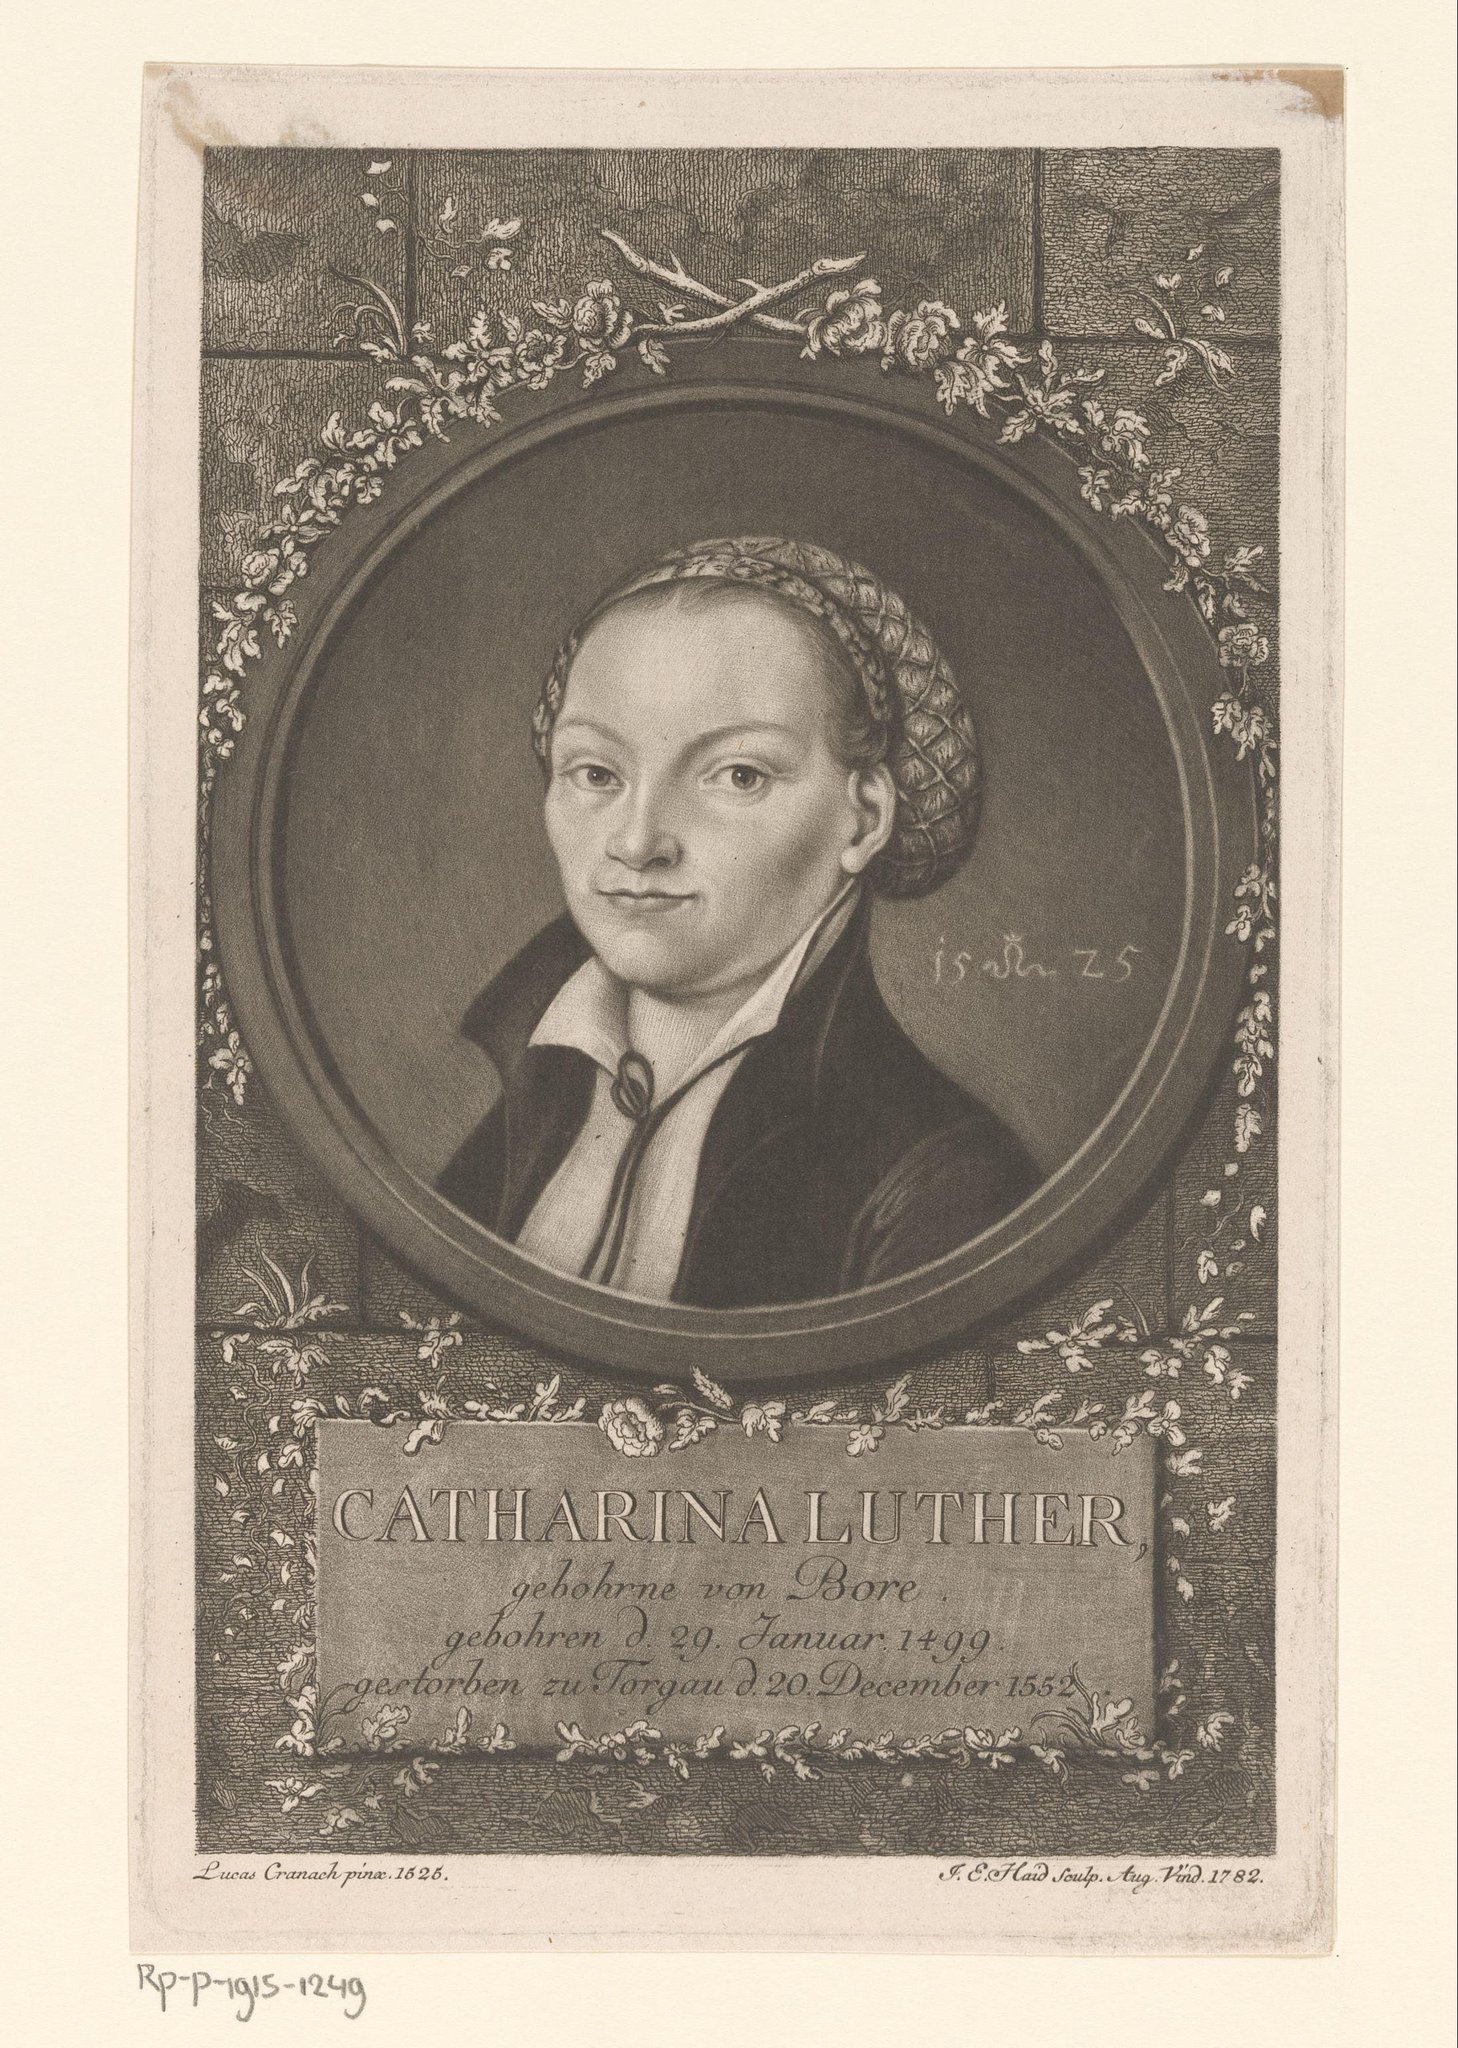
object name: print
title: Portret van Katharina von Bora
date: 1782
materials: paper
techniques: etching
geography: augsburg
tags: trees: laurel (branch, stick), historical persons - bb - woman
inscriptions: collector's mark: Lugt 2228